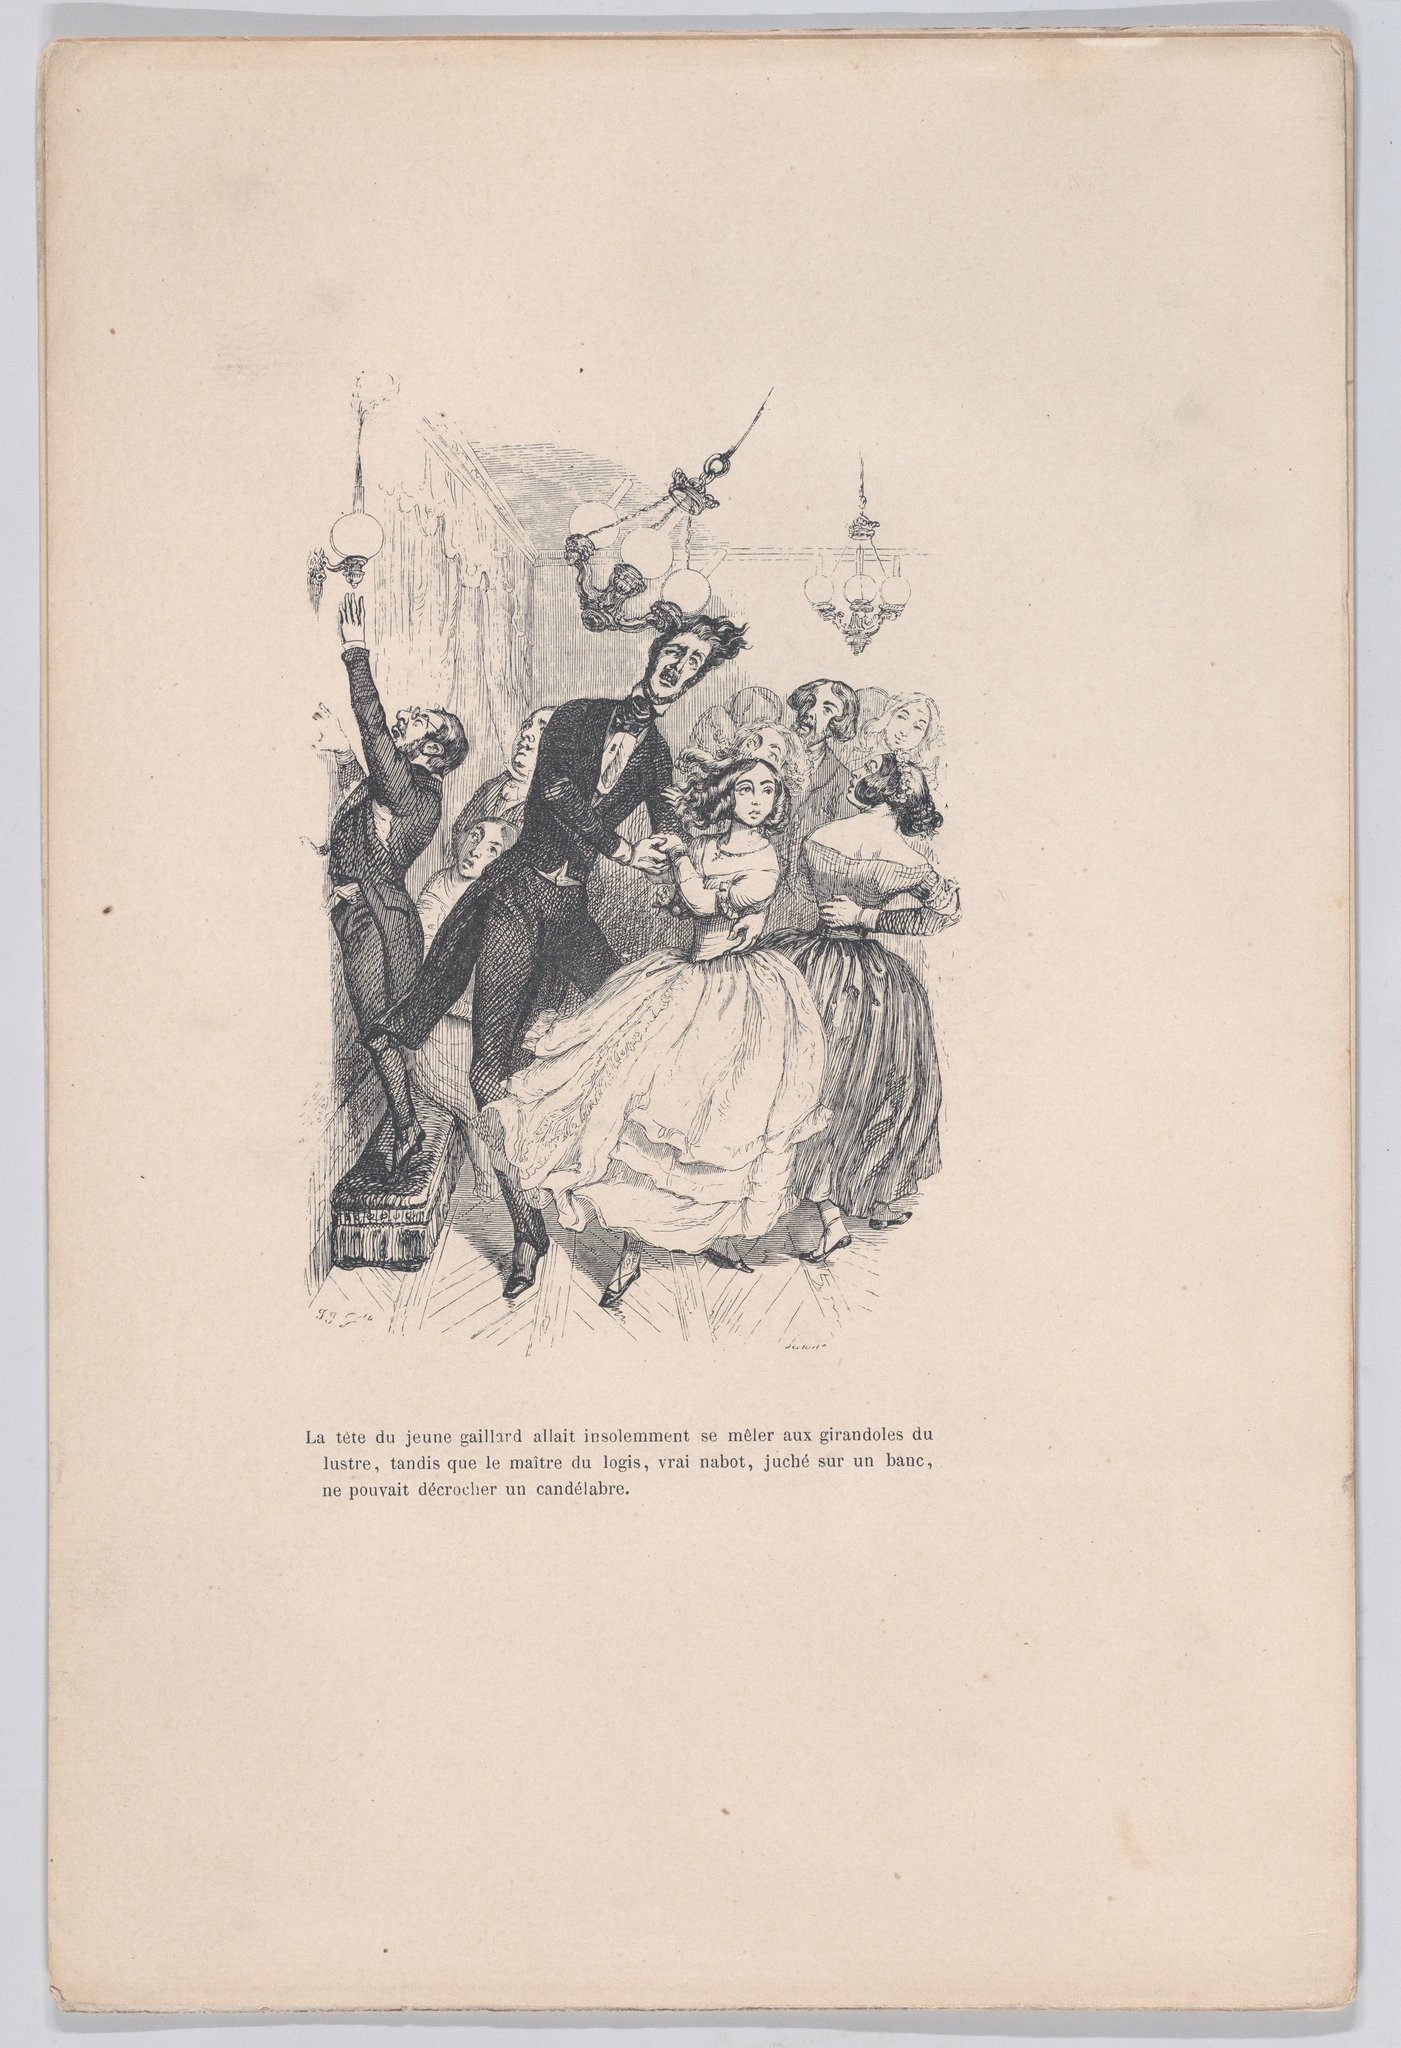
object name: print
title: The head of the young fellow insolently mingled with the candlesticks of the chandelier, from "Little Miseries of Human Life"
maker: j. j. grandville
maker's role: illustrator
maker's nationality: french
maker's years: 1803-1847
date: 1843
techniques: engraving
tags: men,women